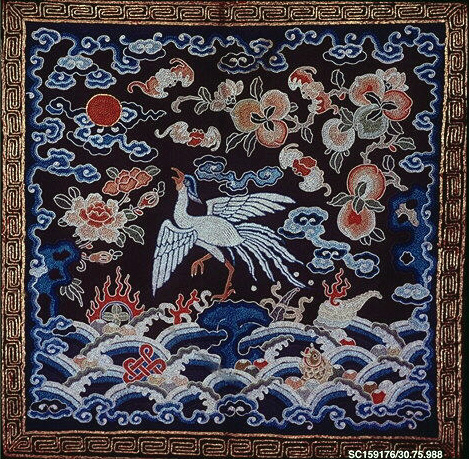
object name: rank badge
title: Rank Badge with Silver Pheasant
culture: chinese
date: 1701-1800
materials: metal thread, silk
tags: bats,pheasants,fish